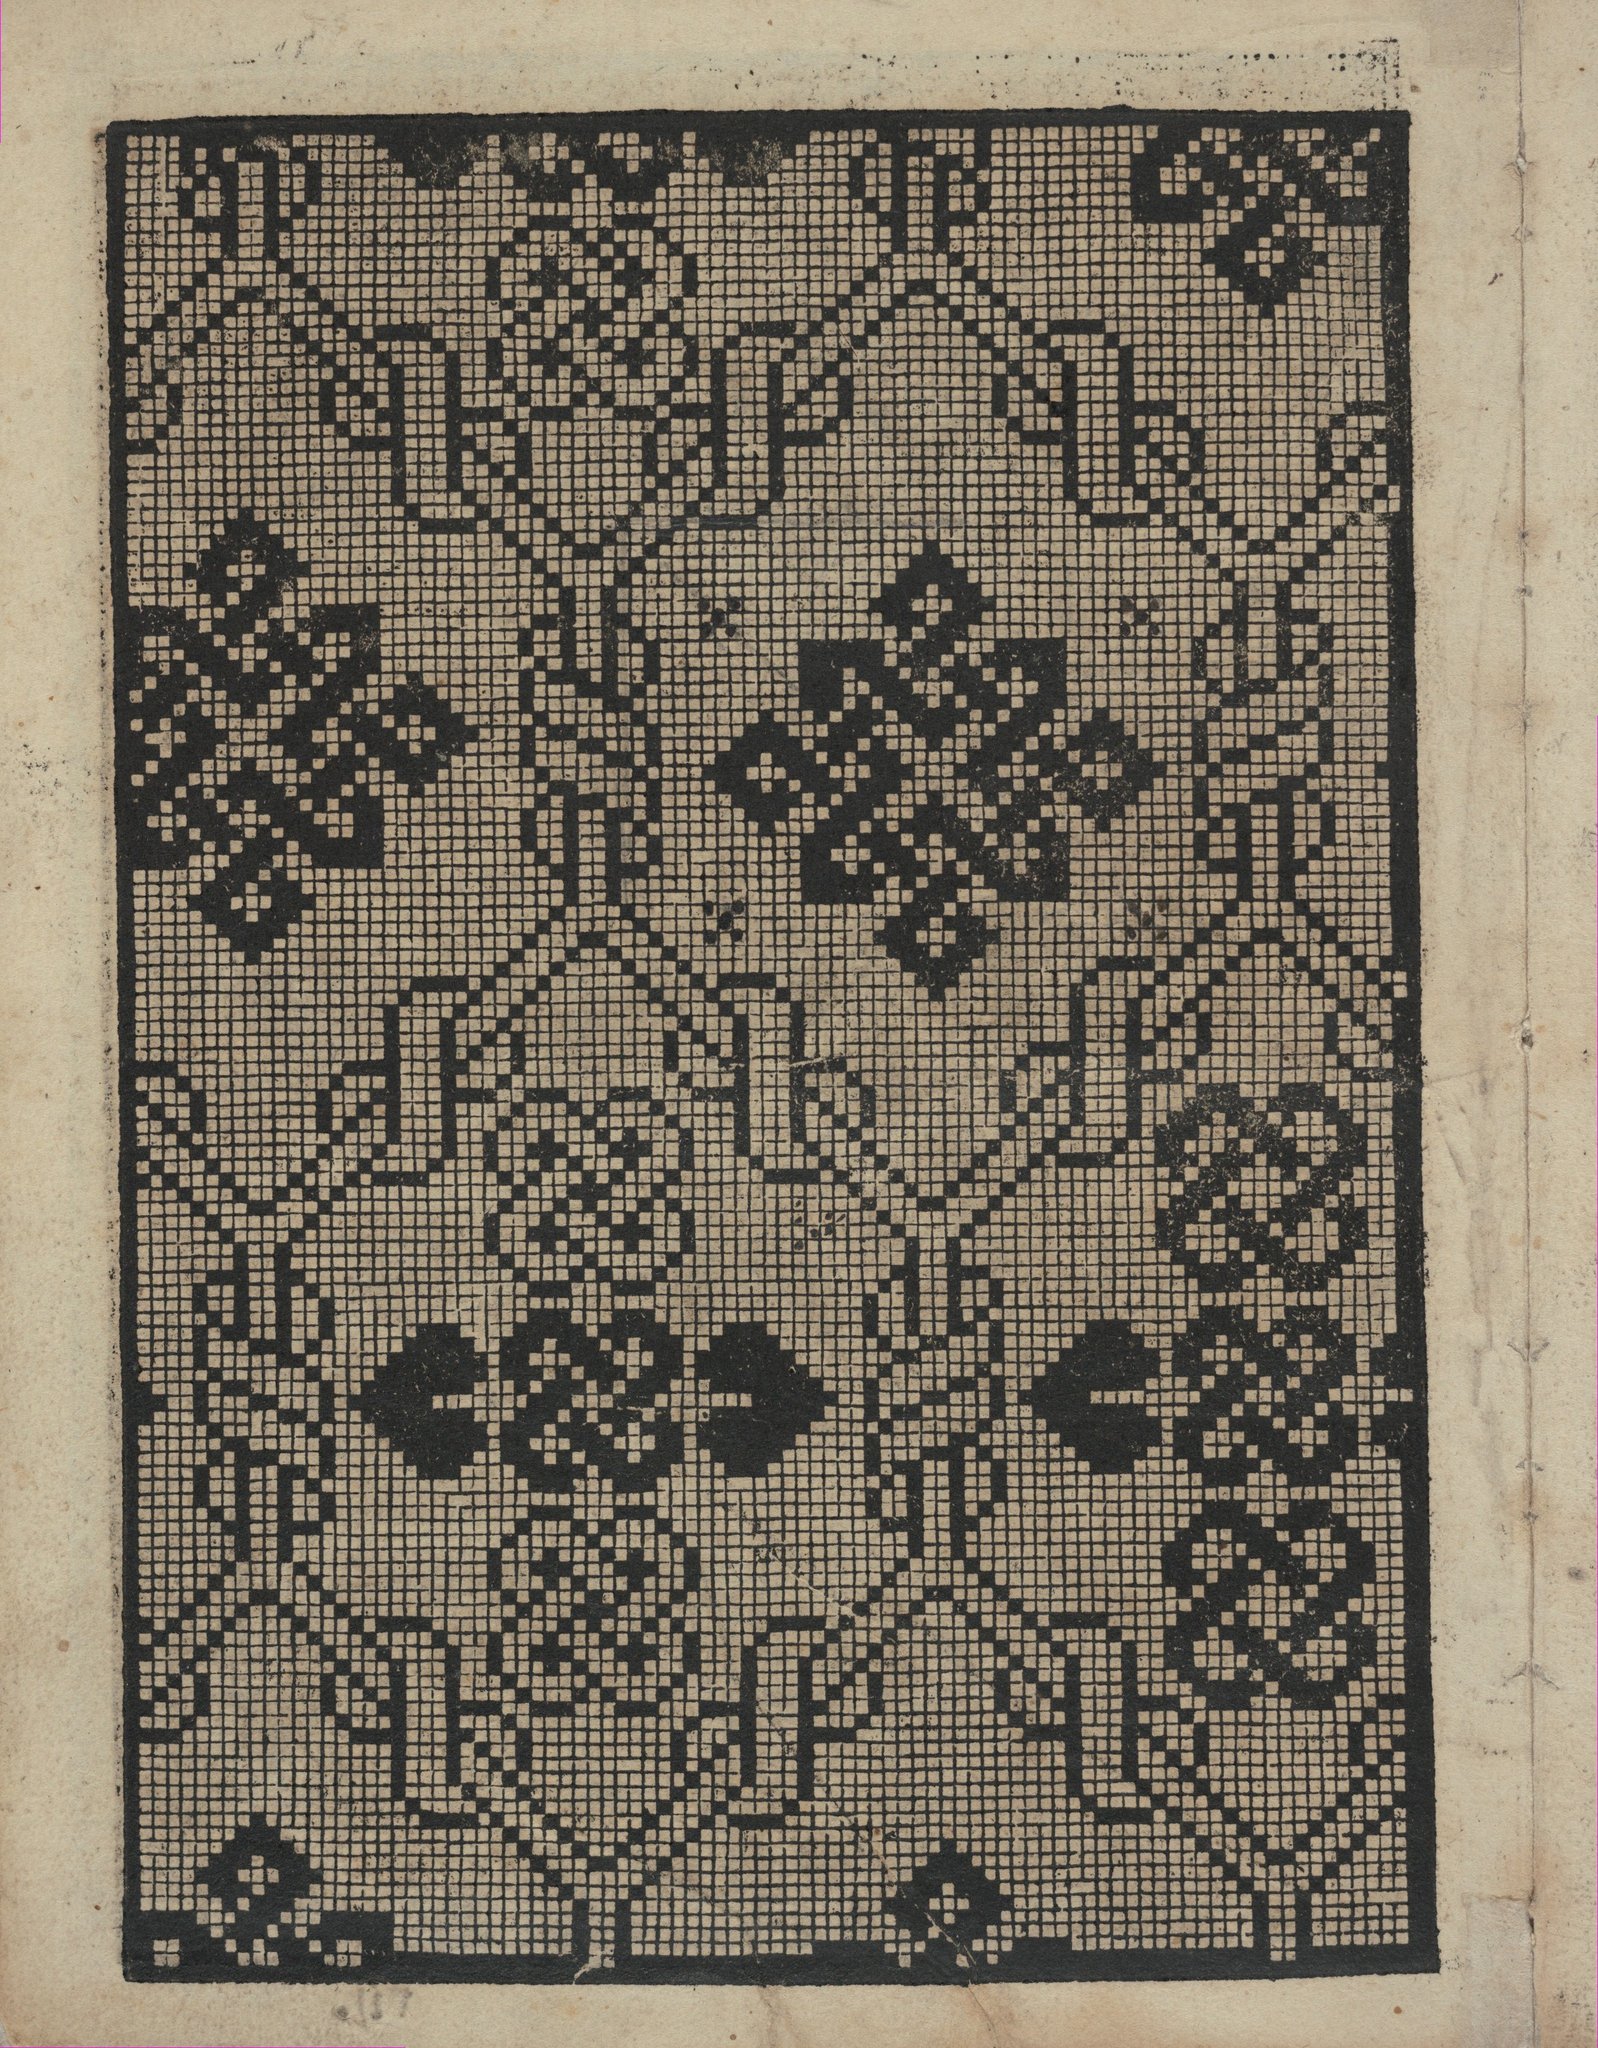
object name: book print ornament architecture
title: Libbretto nouellamete composto per maestro Domenico da Sera...lauorare di ogni sorte di punti, page 7 (verso)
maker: domenico da sera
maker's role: publisher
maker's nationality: french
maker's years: 1500-1599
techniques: woodcut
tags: ornament